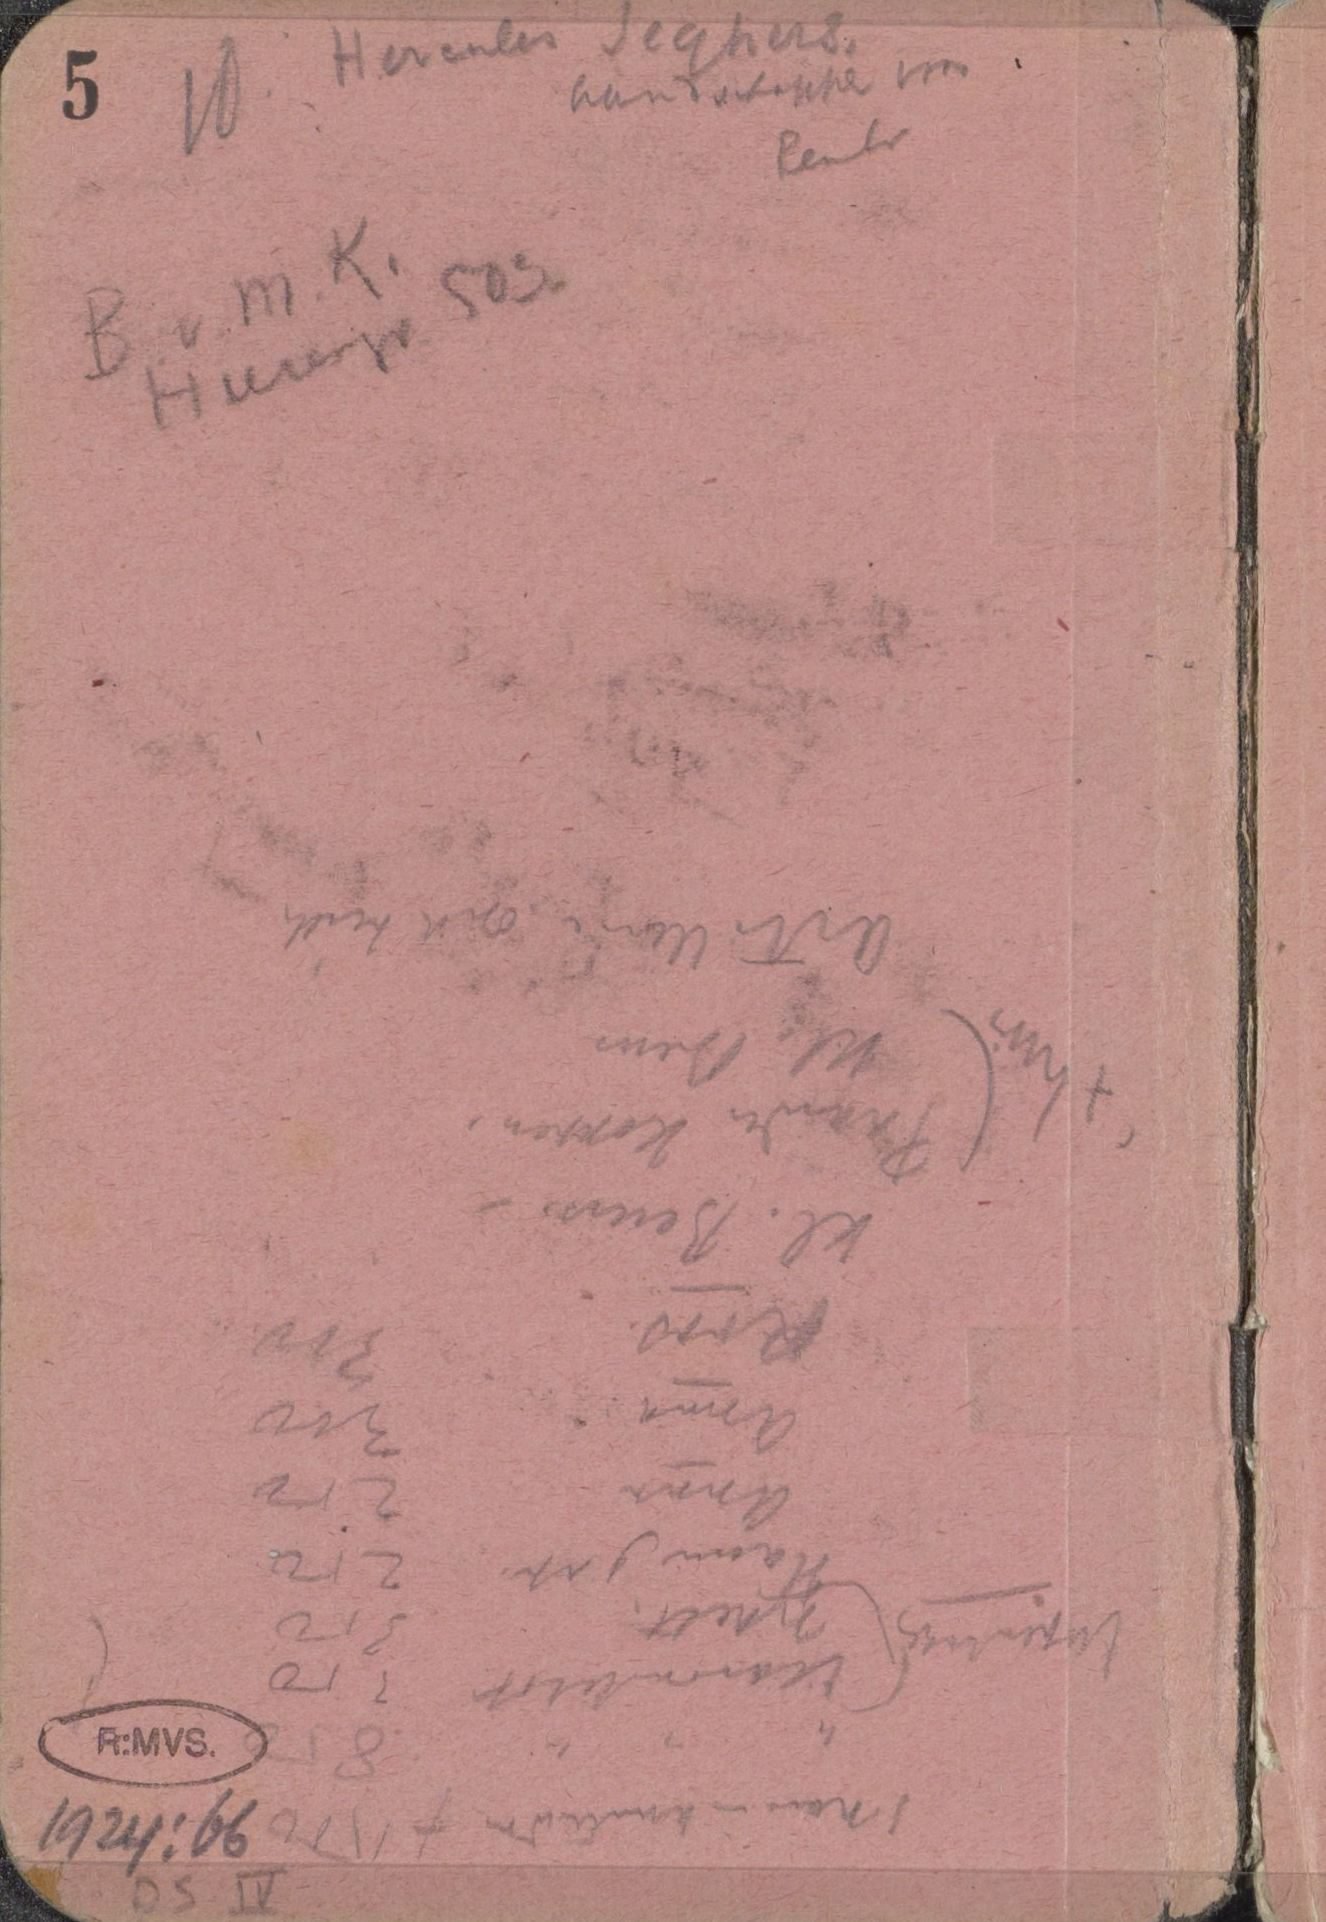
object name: sketchbook leaf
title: Annotaties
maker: george hendrik breitner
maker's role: draughtsman, painter, print maker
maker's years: 1857-1923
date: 1898-1902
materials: chalk, paper, pencil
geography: amsterdam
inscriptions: annotation: ‘10. Hercules Seghers/ [...]/ B. v. M. K./ Heerengr. 503./ [...]’, collector's mark: Lugt 2228, number: ‘5’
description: Pagina 1, voorste schutblad, uit een schetsboek met 42 bladen.